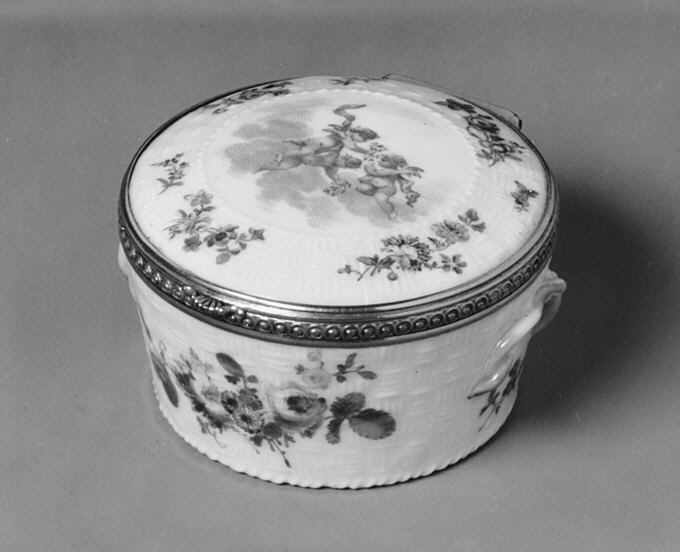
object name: snuffbox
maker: royal porcelain manufactory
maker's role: factory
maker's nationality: danish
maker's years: 1775-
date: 1775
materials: gilt, hard paste porcelain, metal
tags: cupid,flowers